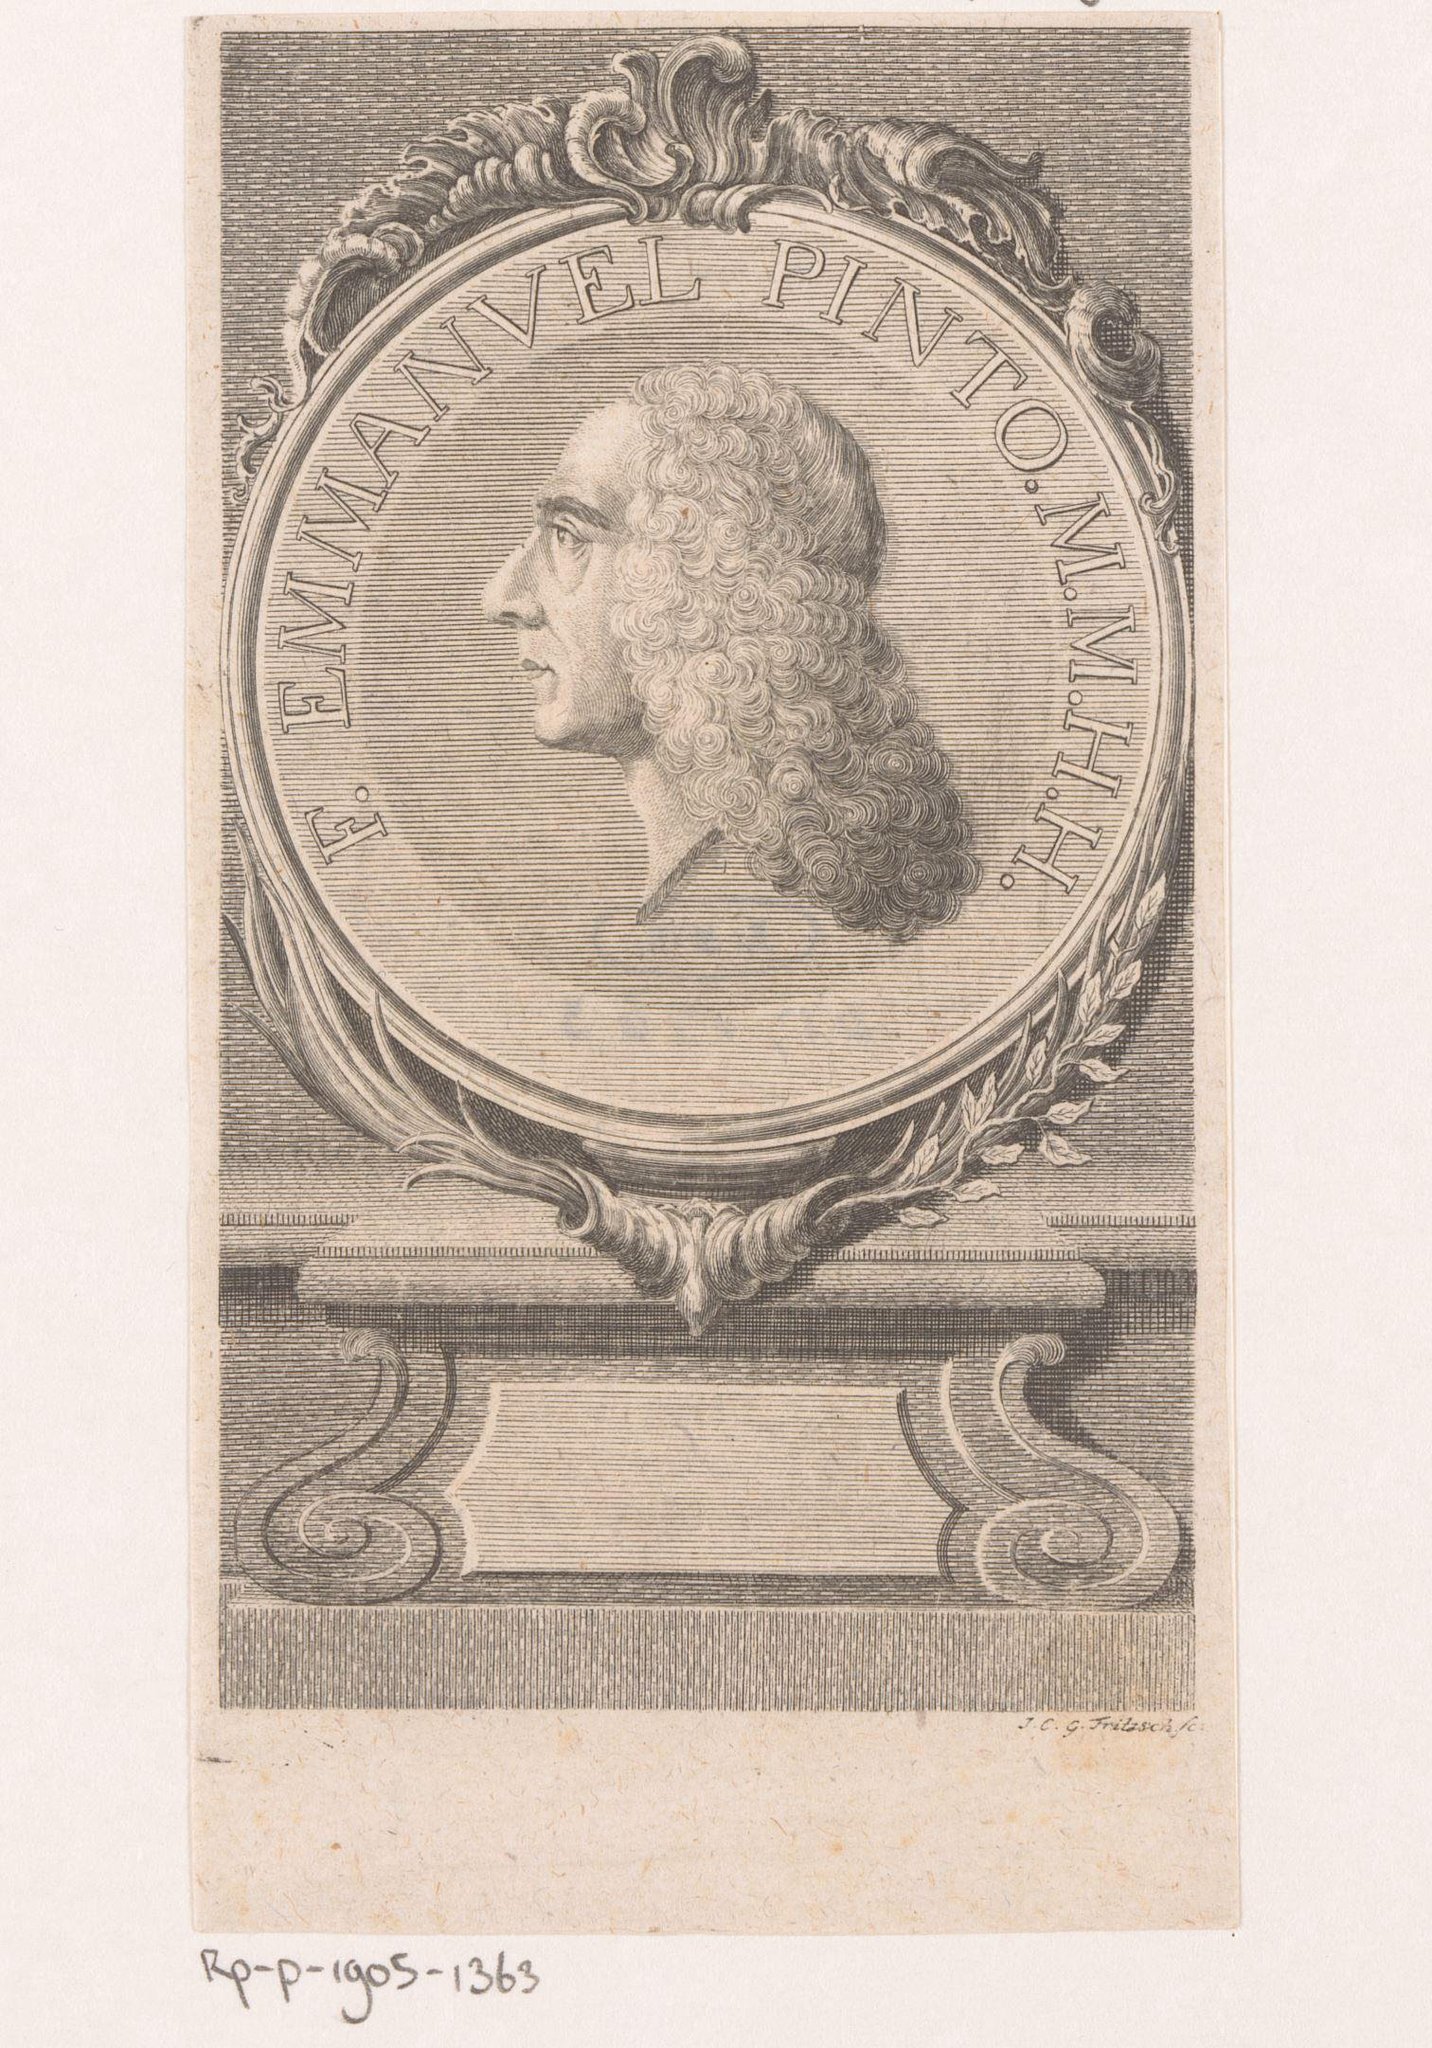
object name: print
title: Portret van Emanuel Pinto da Fonseca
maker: johann christian gottfried fritzsch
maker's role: print maker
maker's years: 1720-1802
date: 1730-1802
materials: paper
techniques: engraving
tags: clergyman, rocaille ornament, ornament ~ medallion, historical persons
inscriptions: collector's mark: Lugt 2228